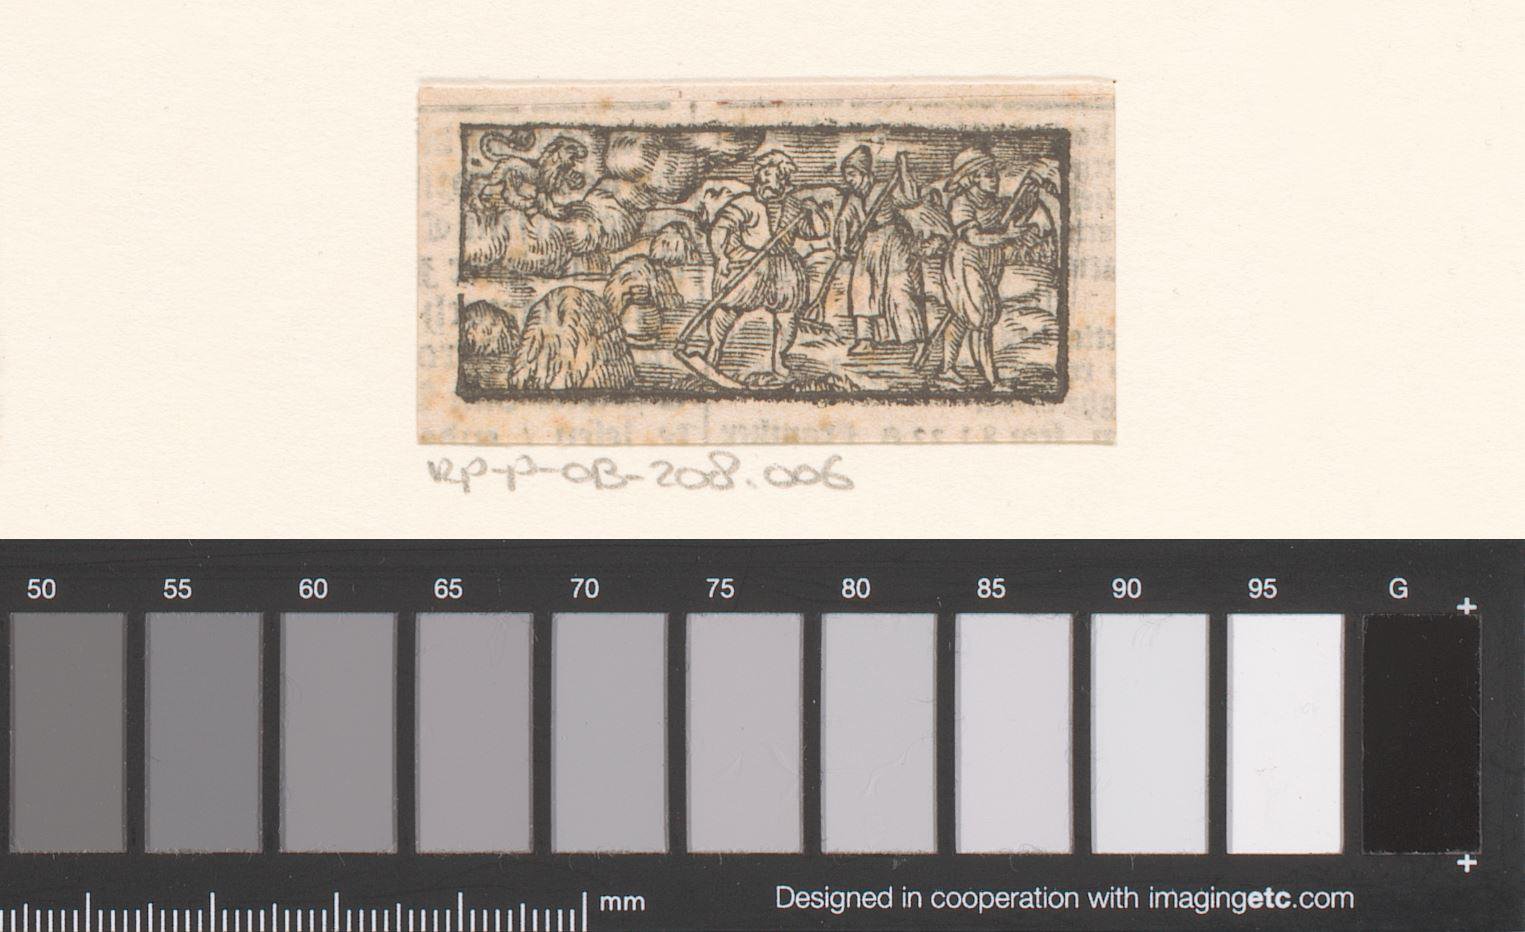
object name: book illustration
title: Juli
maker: Anonymous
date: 1600-1699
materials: paper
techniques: letterpress printing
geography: netherlands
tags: harvest, july and its 'labours' (+ with leo (july)), reaping, picking, mowing ~ harvest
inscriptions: collector's mark: Lugt 698, collector's mark: Lugt 240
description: Een hooier en twee maaiers werkend op het land. Linksboven een leeuw.